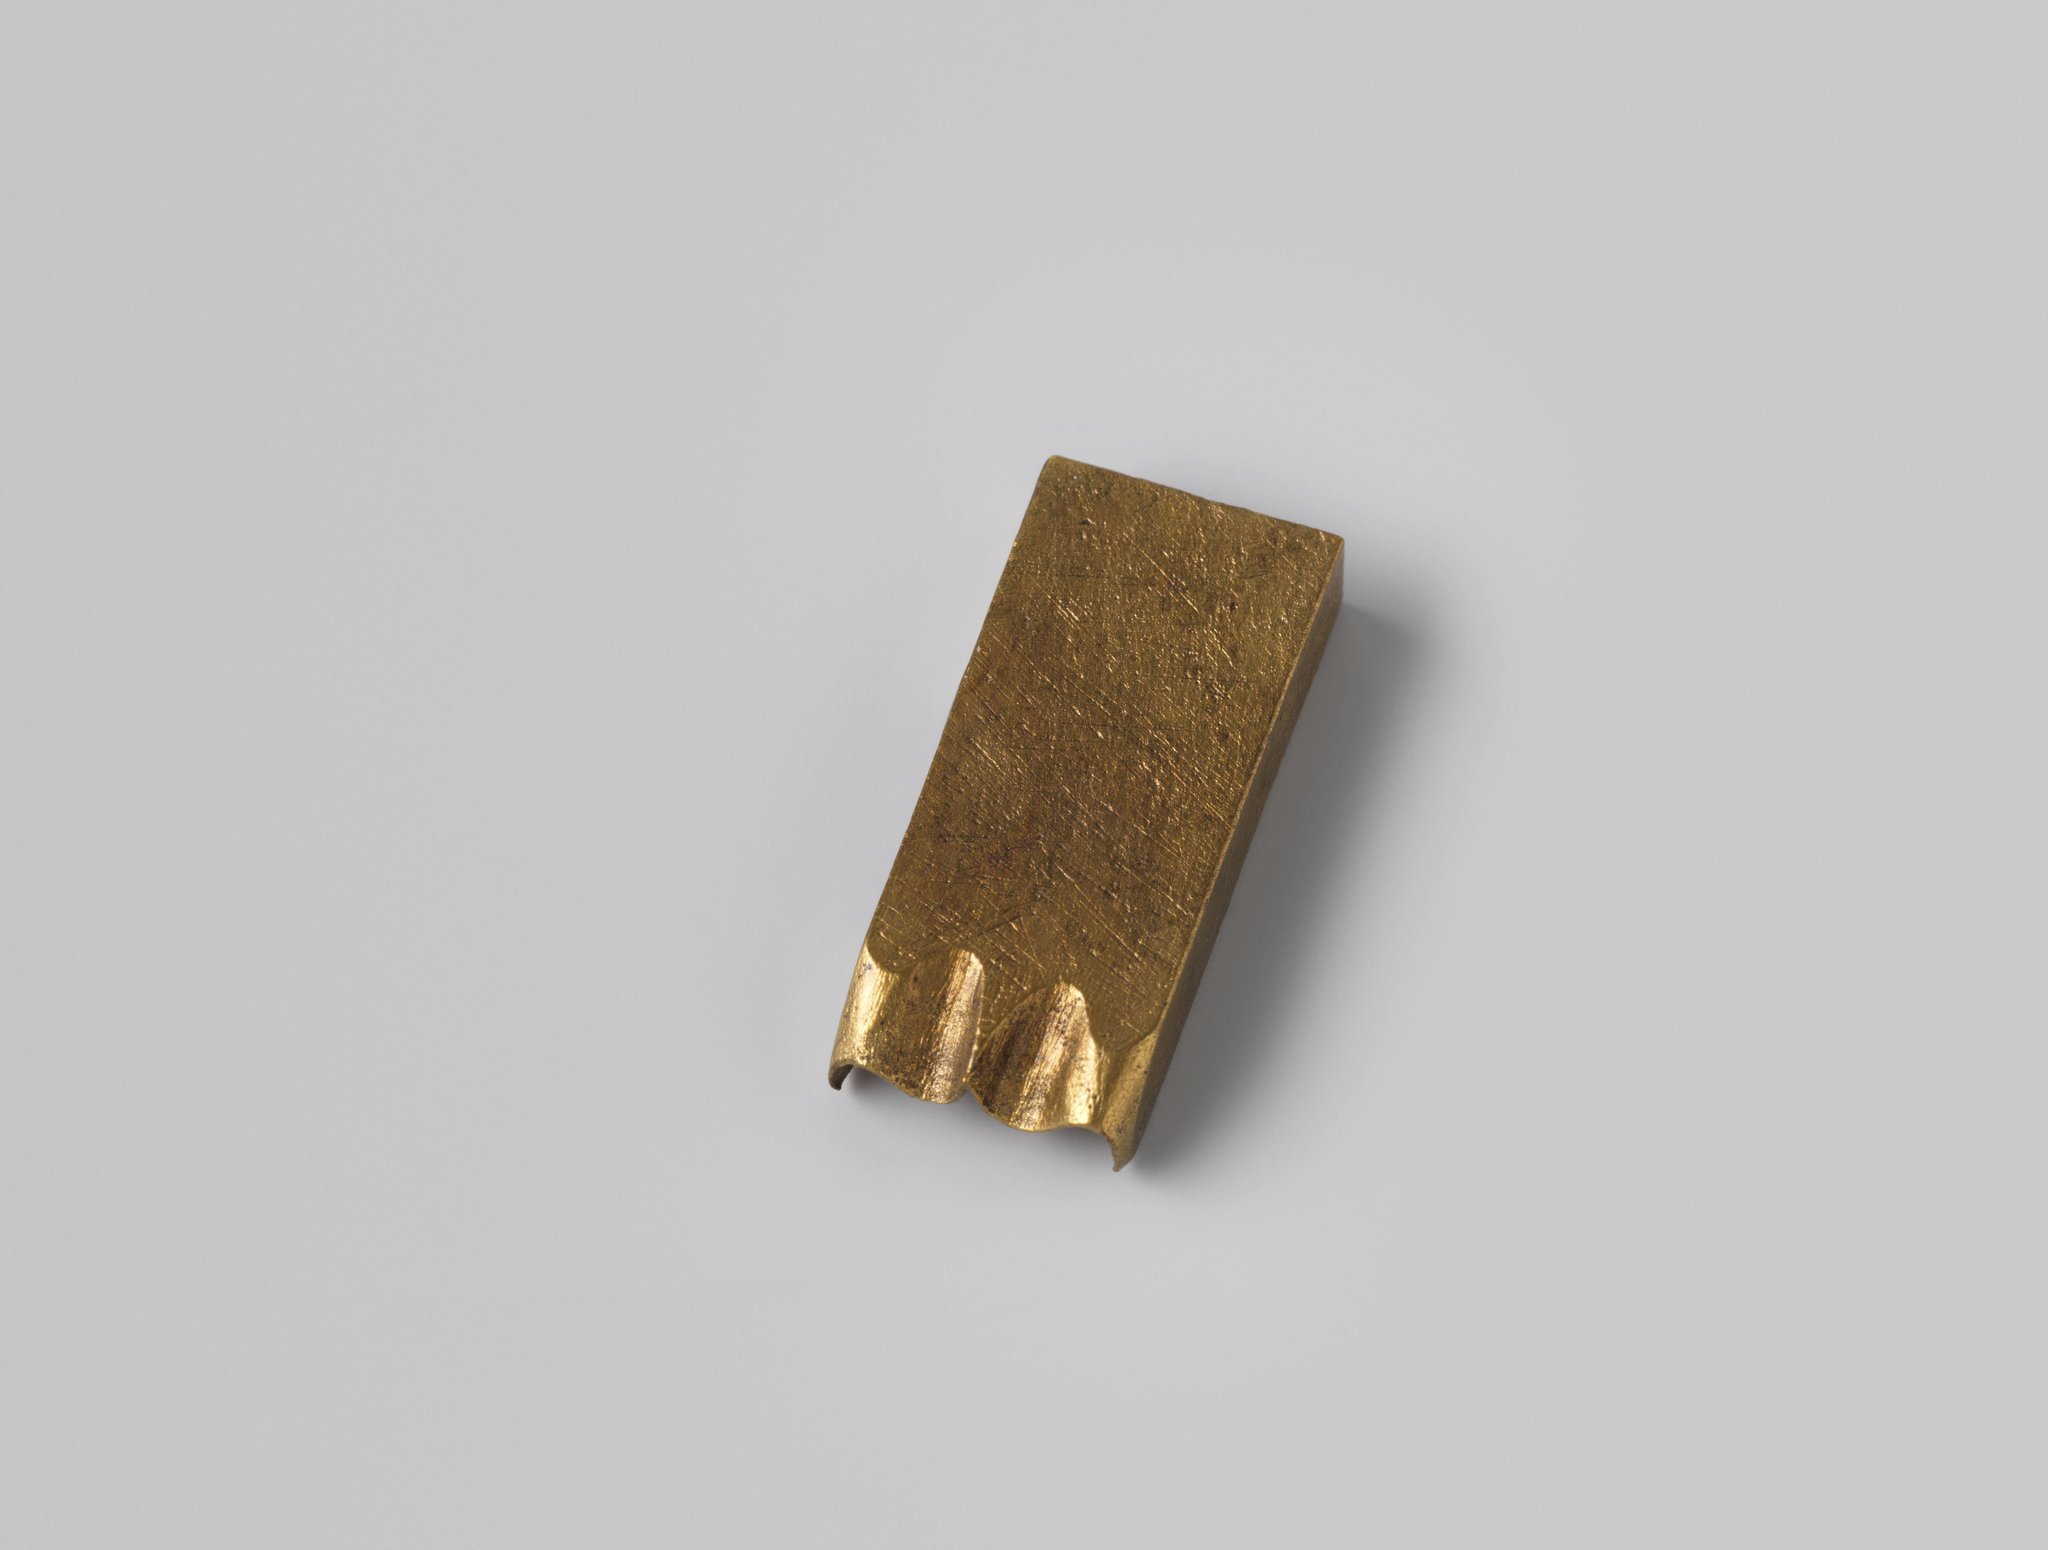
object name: type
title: Printing type with a brace from the wreck of the Dutch East India ship Hollandia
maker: Anonymous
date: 1700-1743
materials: copper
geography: netherlands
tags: verenigde oostindische compagnie, hollandia (schip), annet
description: Stamp; rectangular, flat small bar, one end cut into a relieved accolade-shaped character.